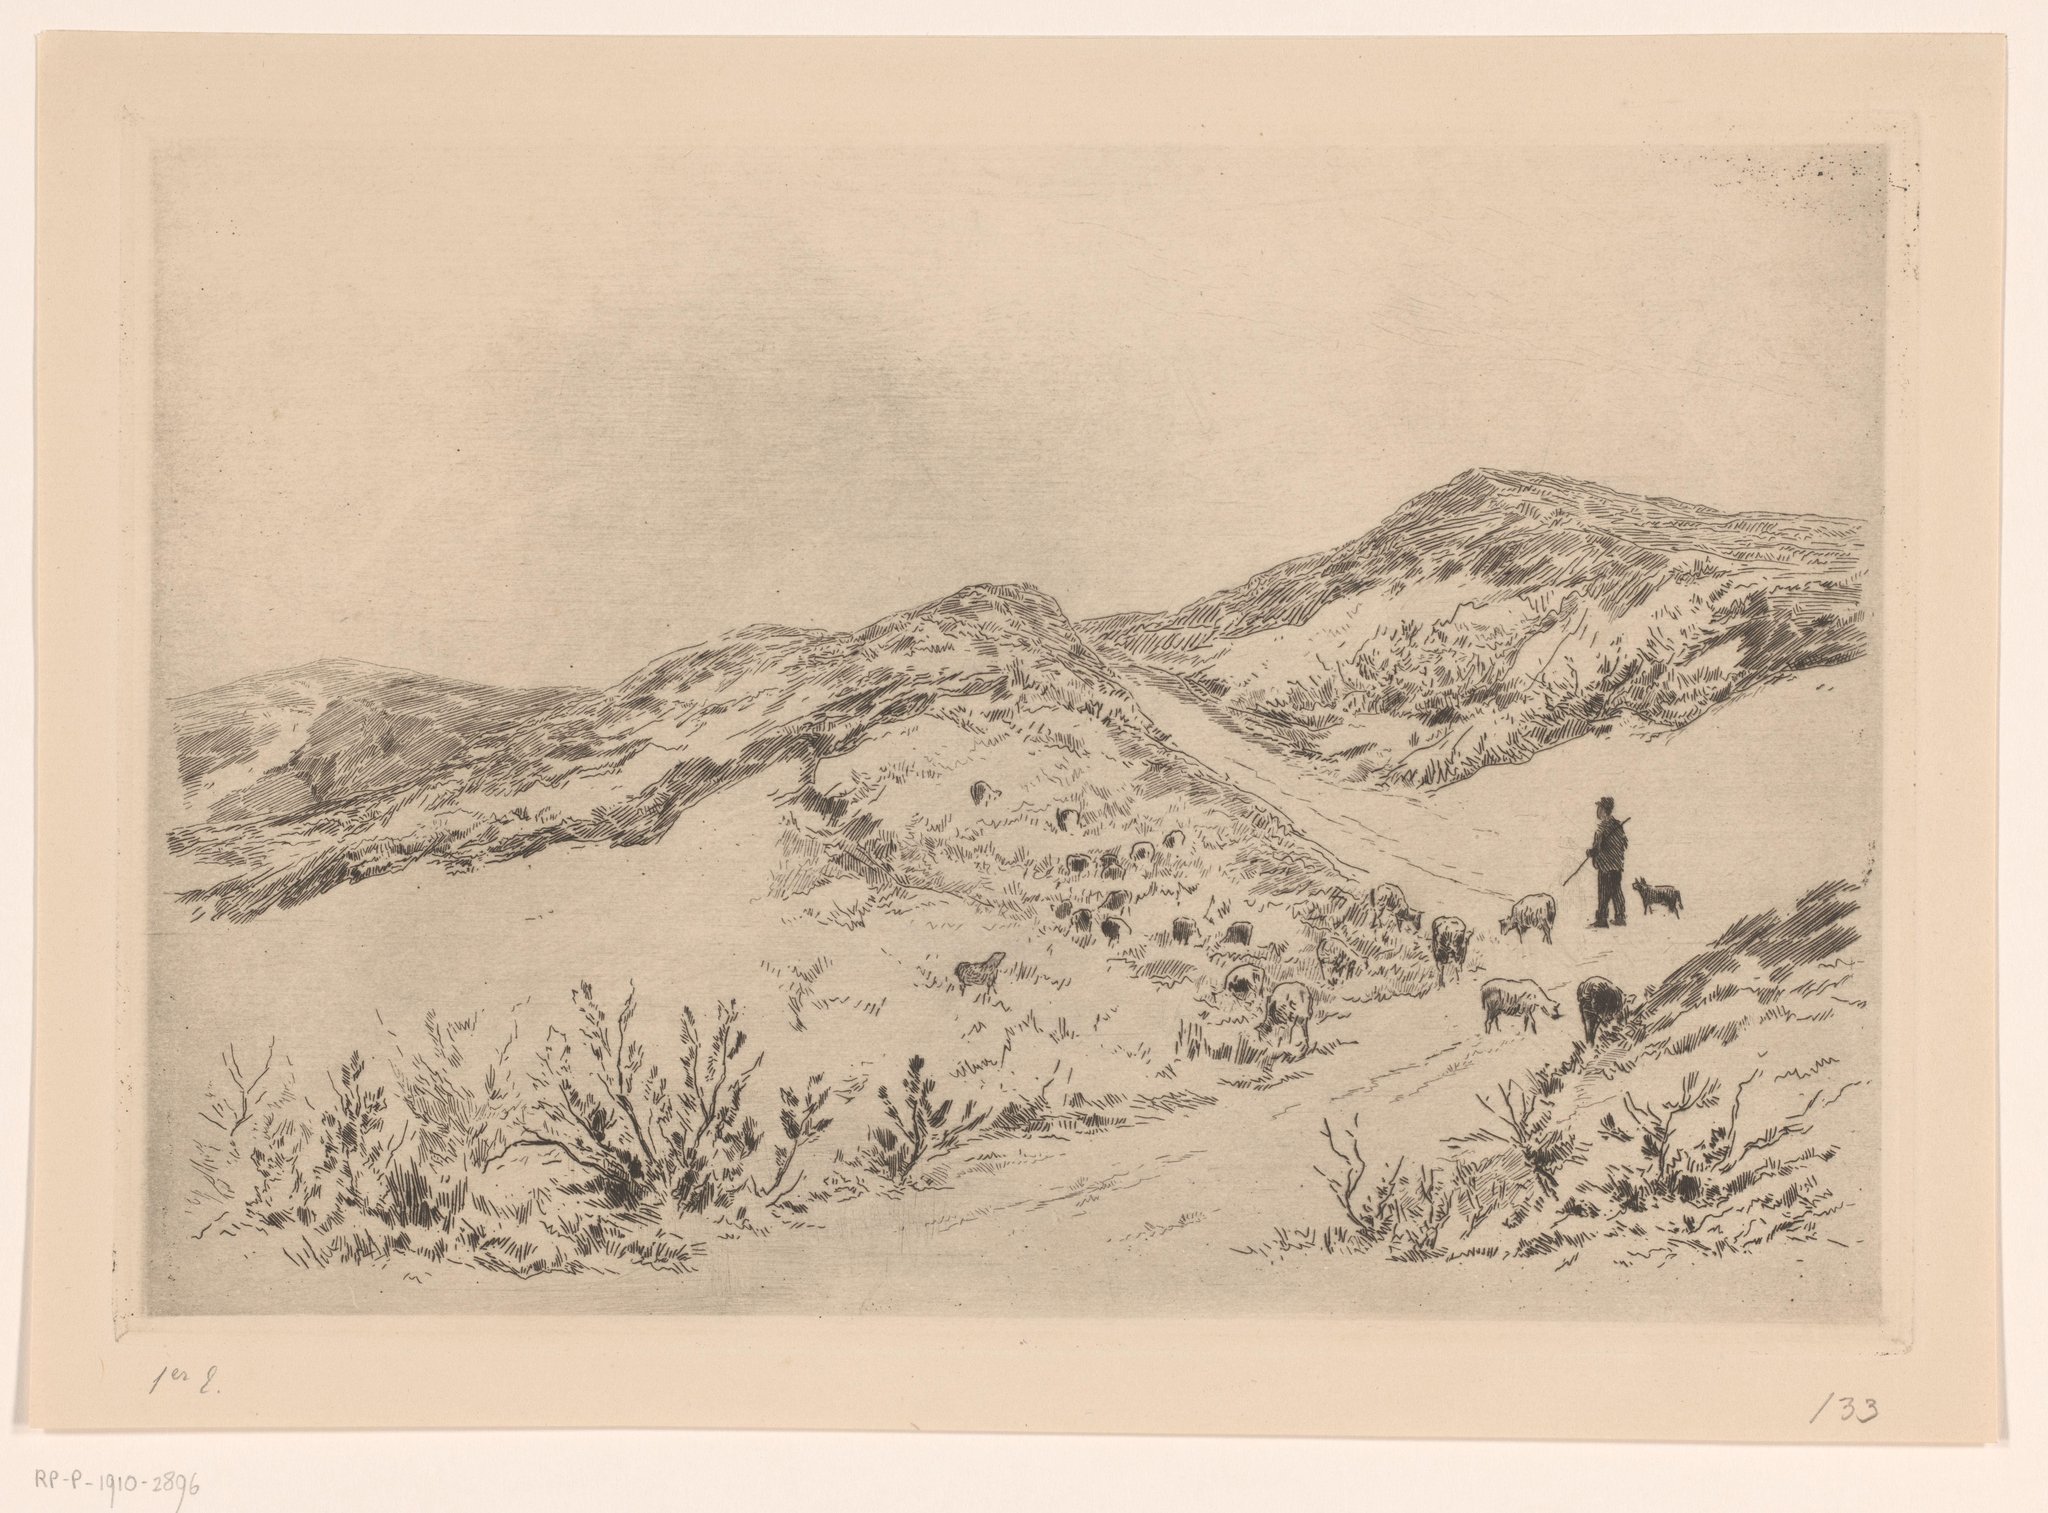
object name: print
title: Sketches of Holland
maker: carel nicolaas storm van s-gravesande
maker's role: draughtsman, print maker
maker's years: 1841-1924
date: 1880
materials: paper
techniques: etching, intaglio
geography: netherlands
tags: low hill country (+ landscape with figures, staffage), herd, flock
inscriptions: collector's mark: Lugt 2228